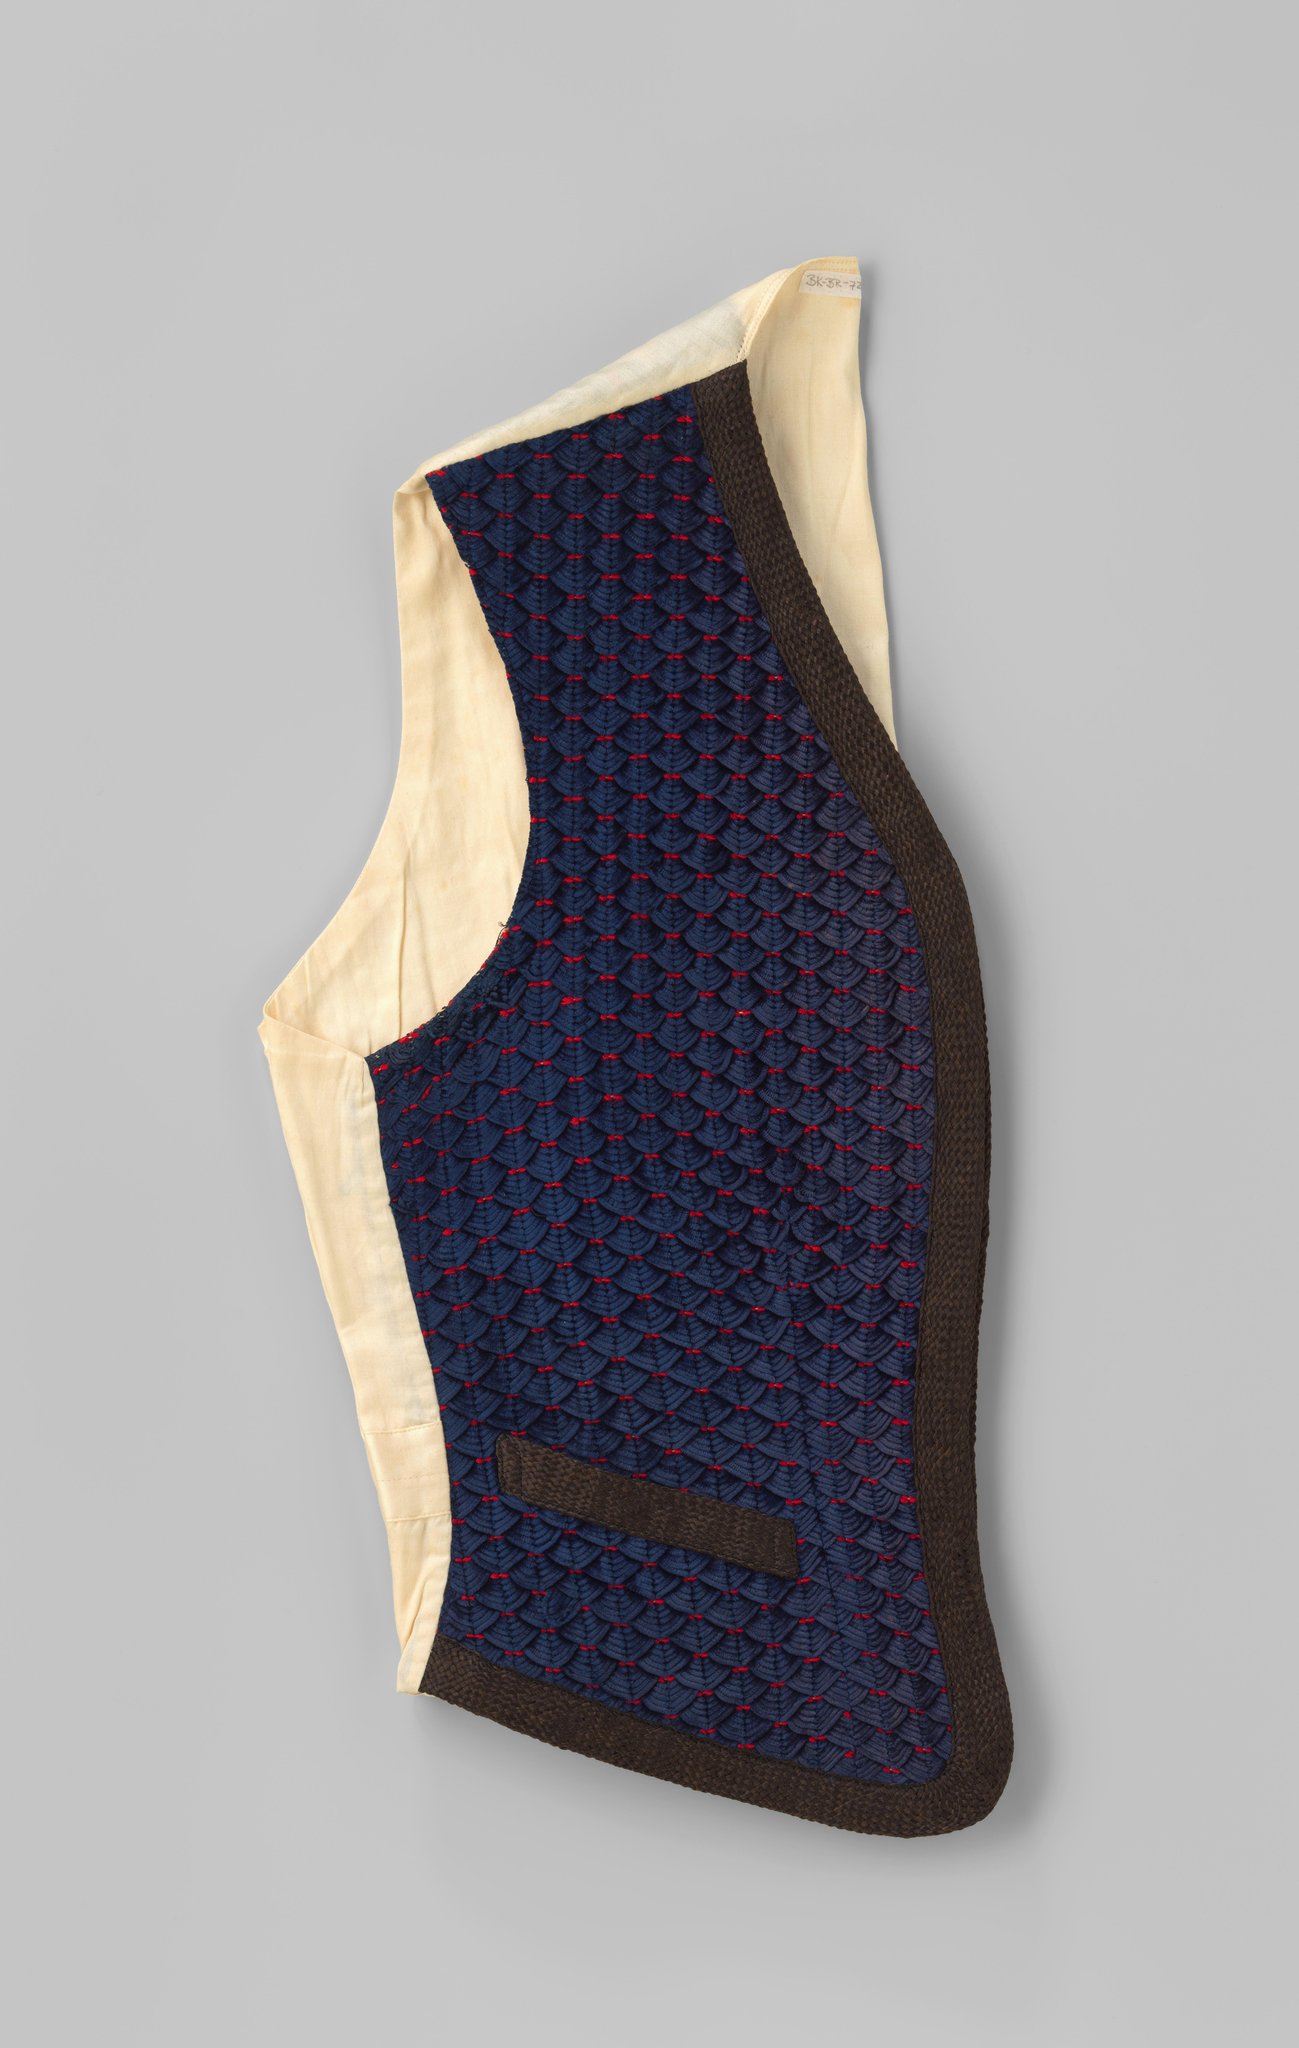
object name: womenswear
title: Vest met drie zakken en zes zwarte knopen van blauw fluweel met geribde schubben en een rood werkje, afgezet met breed zwart gevlochten band; achterkant van wit katoen.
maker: Anonymous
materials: cotton, velvet, wool